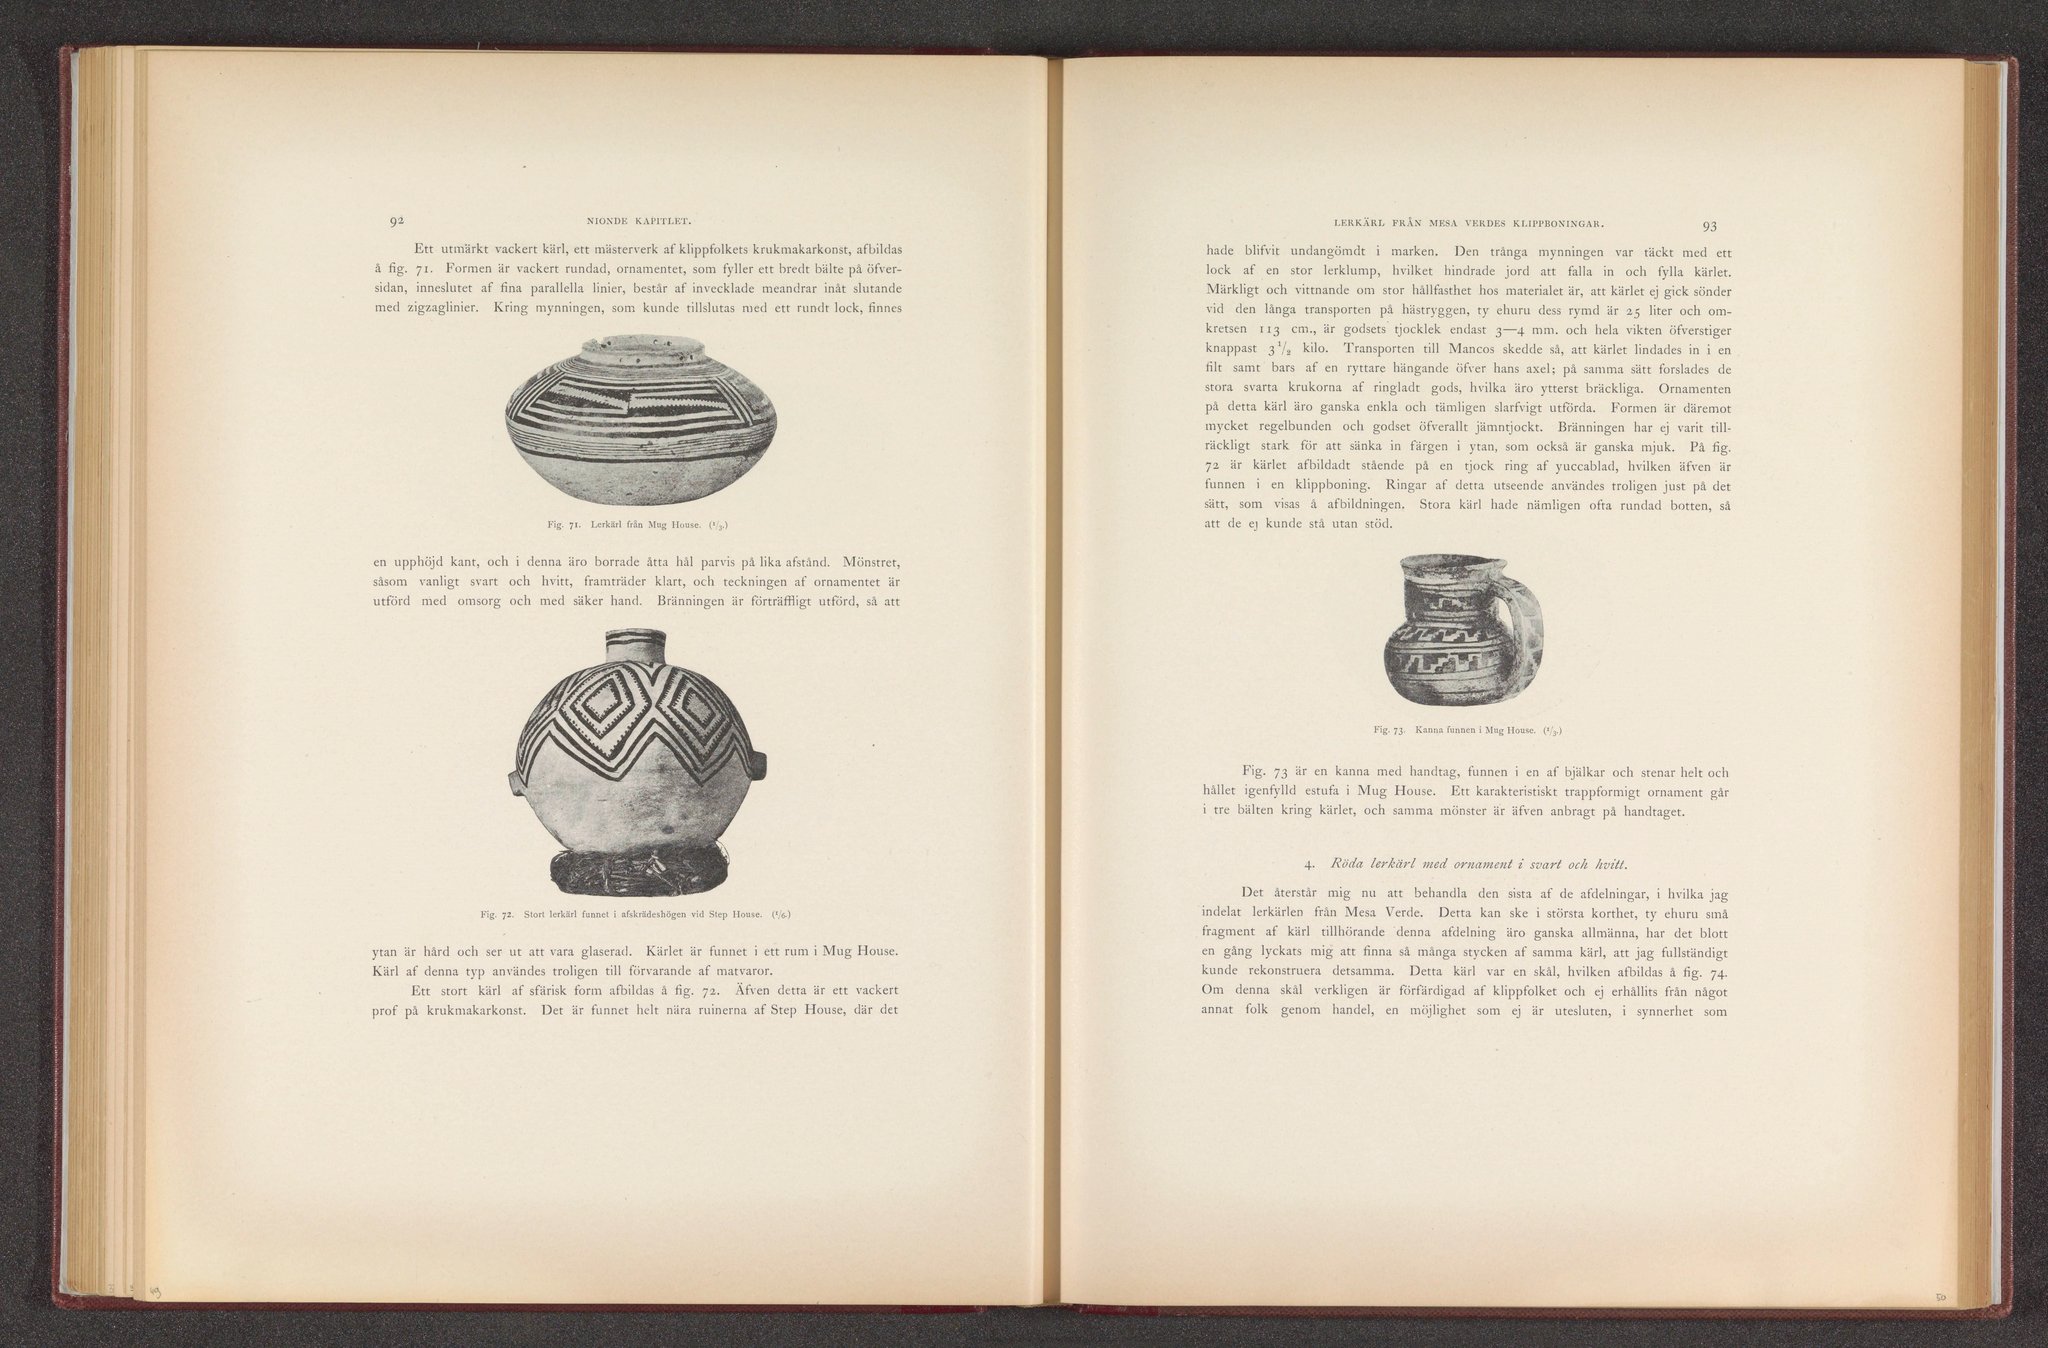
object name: page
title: Kanna funnen i Mug House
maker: gustaf nordenskiöld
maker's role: fotograaf, schrijver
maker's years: 1868-1895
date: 1891-1893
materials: paper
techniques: autotype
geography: vienna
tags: container of ceramics: jar, jug, pot, vase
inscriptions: number: ‘Fig. 73.’